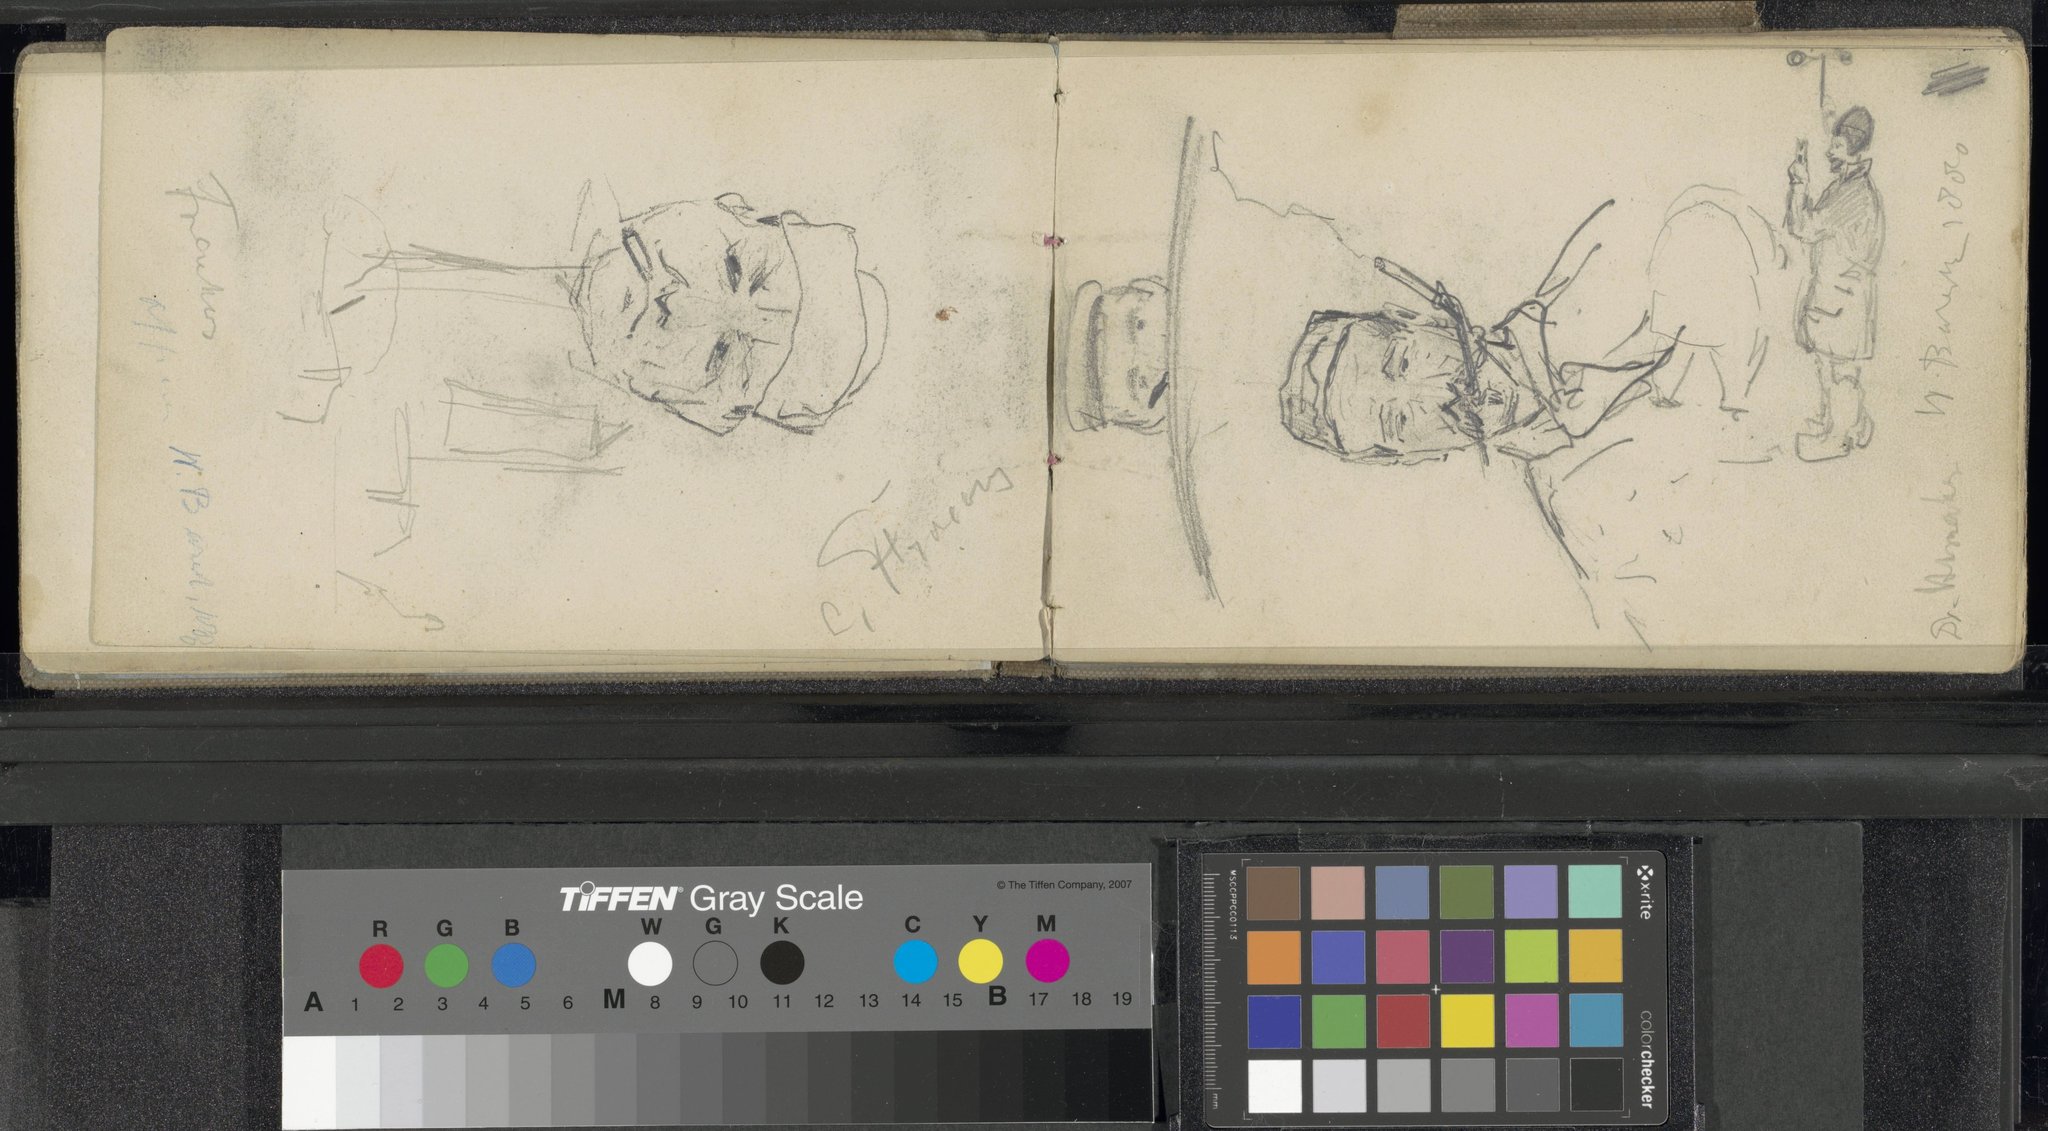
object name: sketchbook leaf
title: Figuurstudies en een portret van de scheepsarts dr. W. Hamaker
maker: louis apol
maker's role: draughtsman, painter, print maker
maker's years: 1850-1936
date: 1806-1880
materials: paper, pencil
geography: barentsz sea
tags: adult man, historical persons, tobacco (+ taking (particular) foodstuffs: eating, drinking, smoking, chewing, etc.)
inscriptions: annotation: ‘Dr. Hamaker W. Barents 1880’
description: Blad 4 recto uit een schetsboek met 38 bladen betekend tijdens de expeditie naar Nova Zembla in 1880.